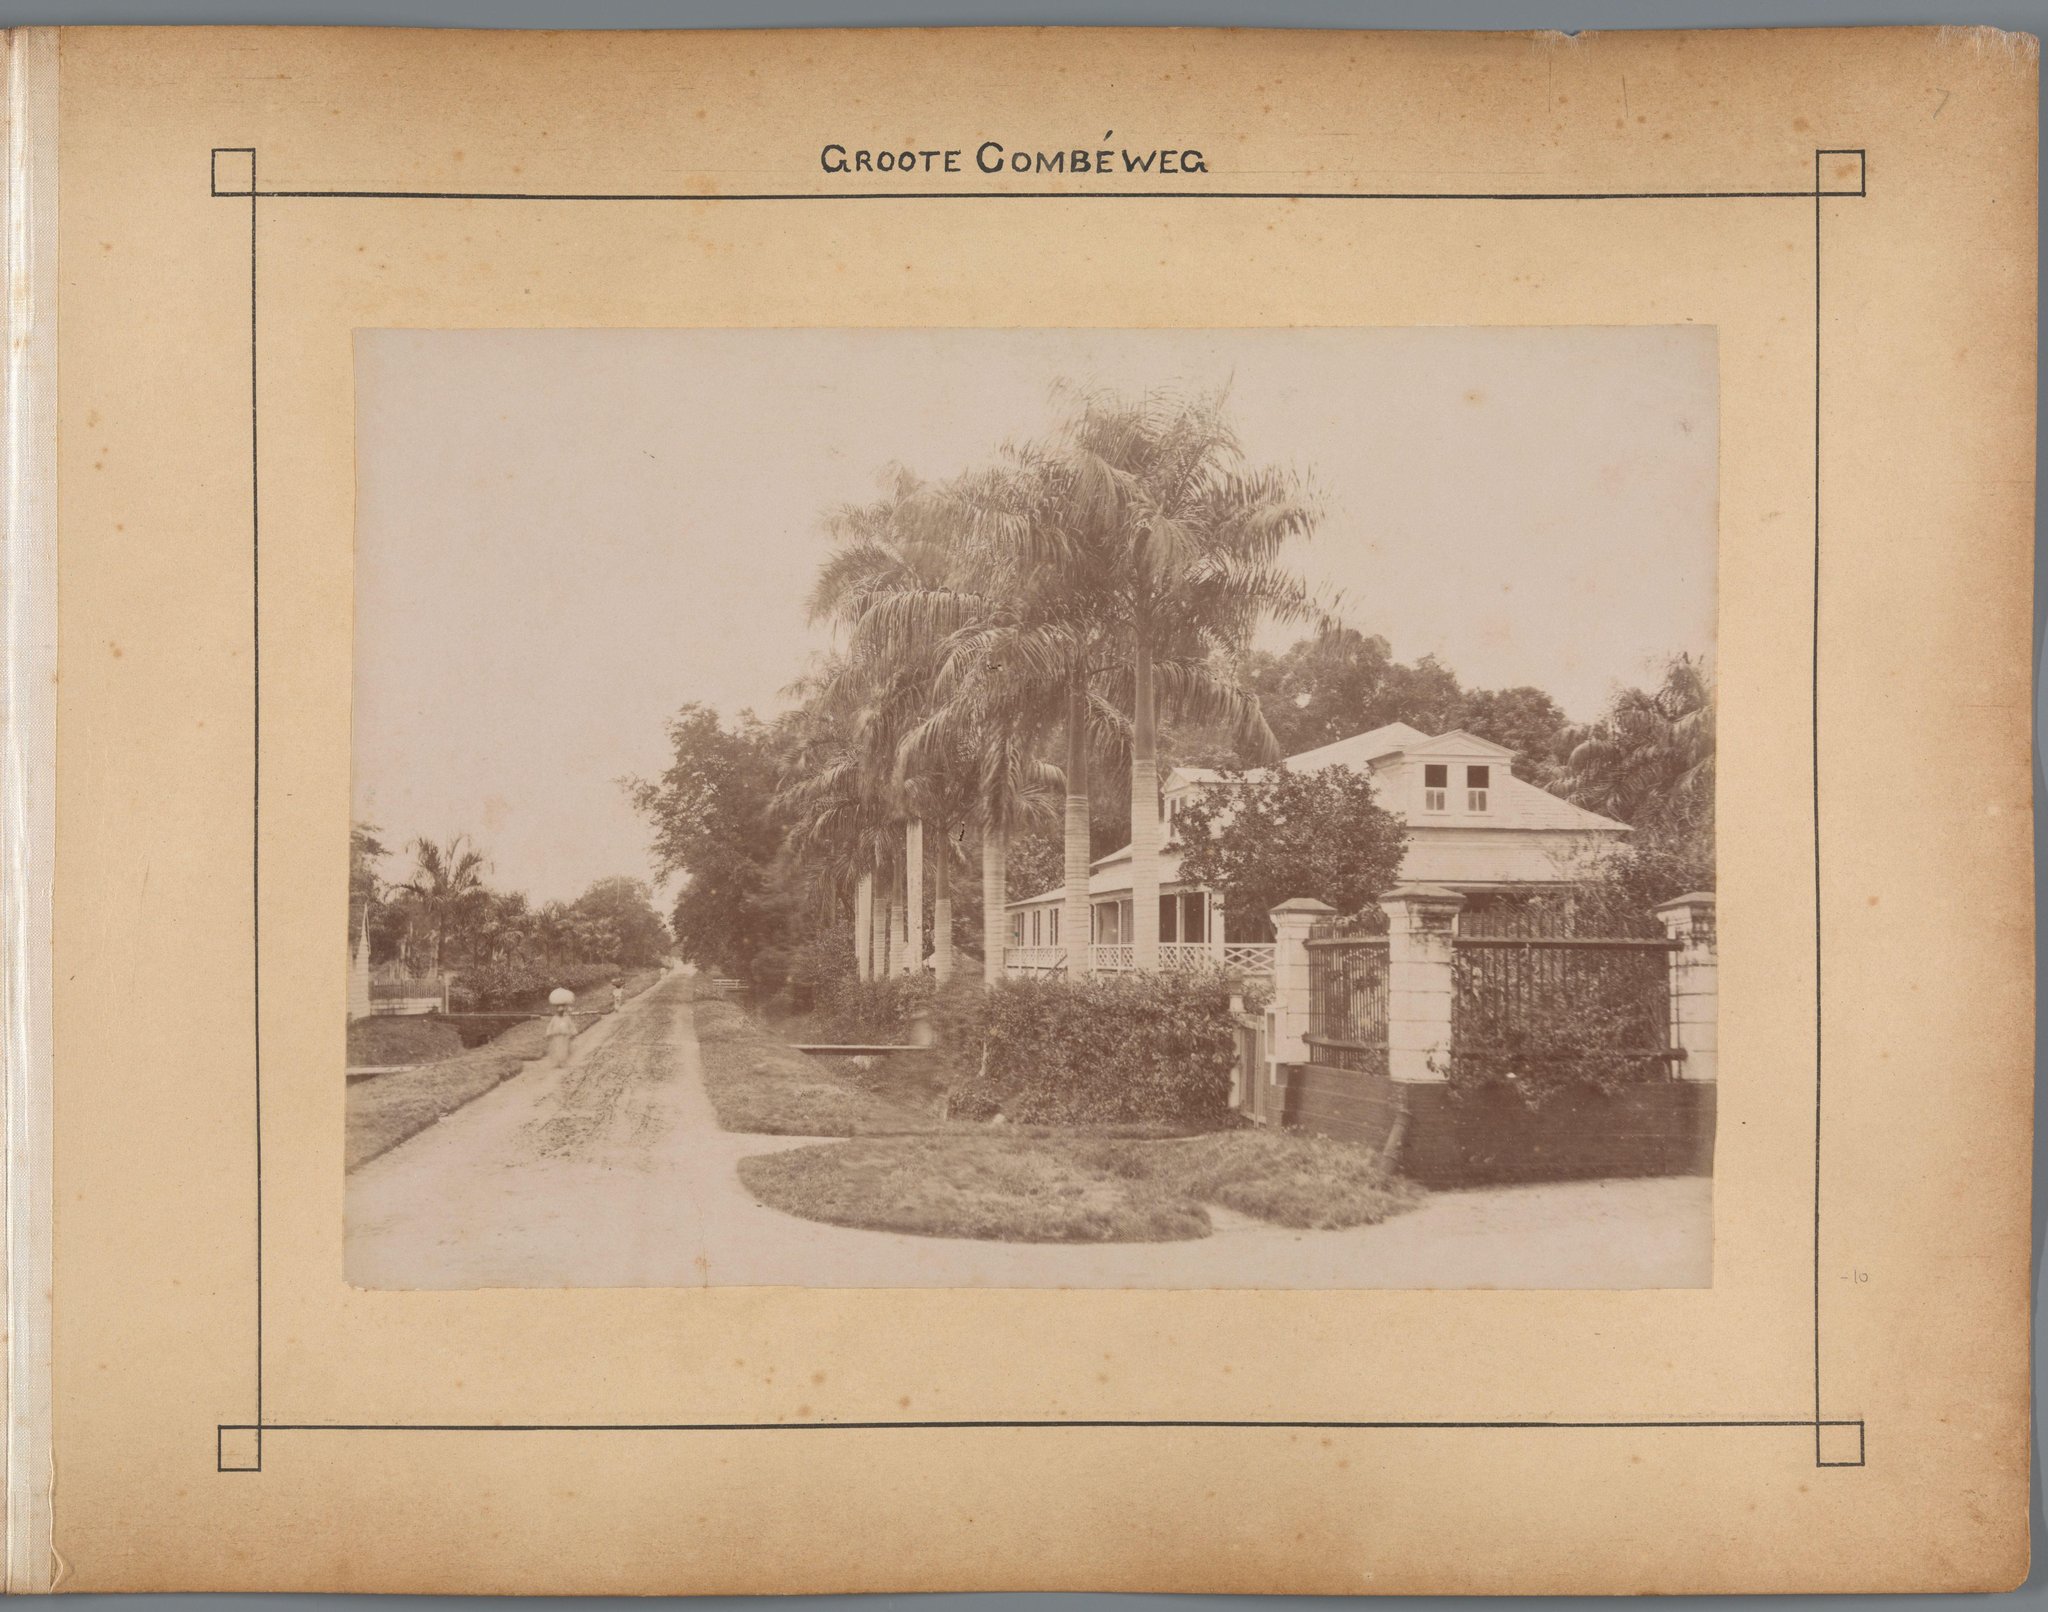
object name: photograph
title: Grote Combéweg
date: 1898-1902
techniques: albumen print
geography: suriname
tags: suriname